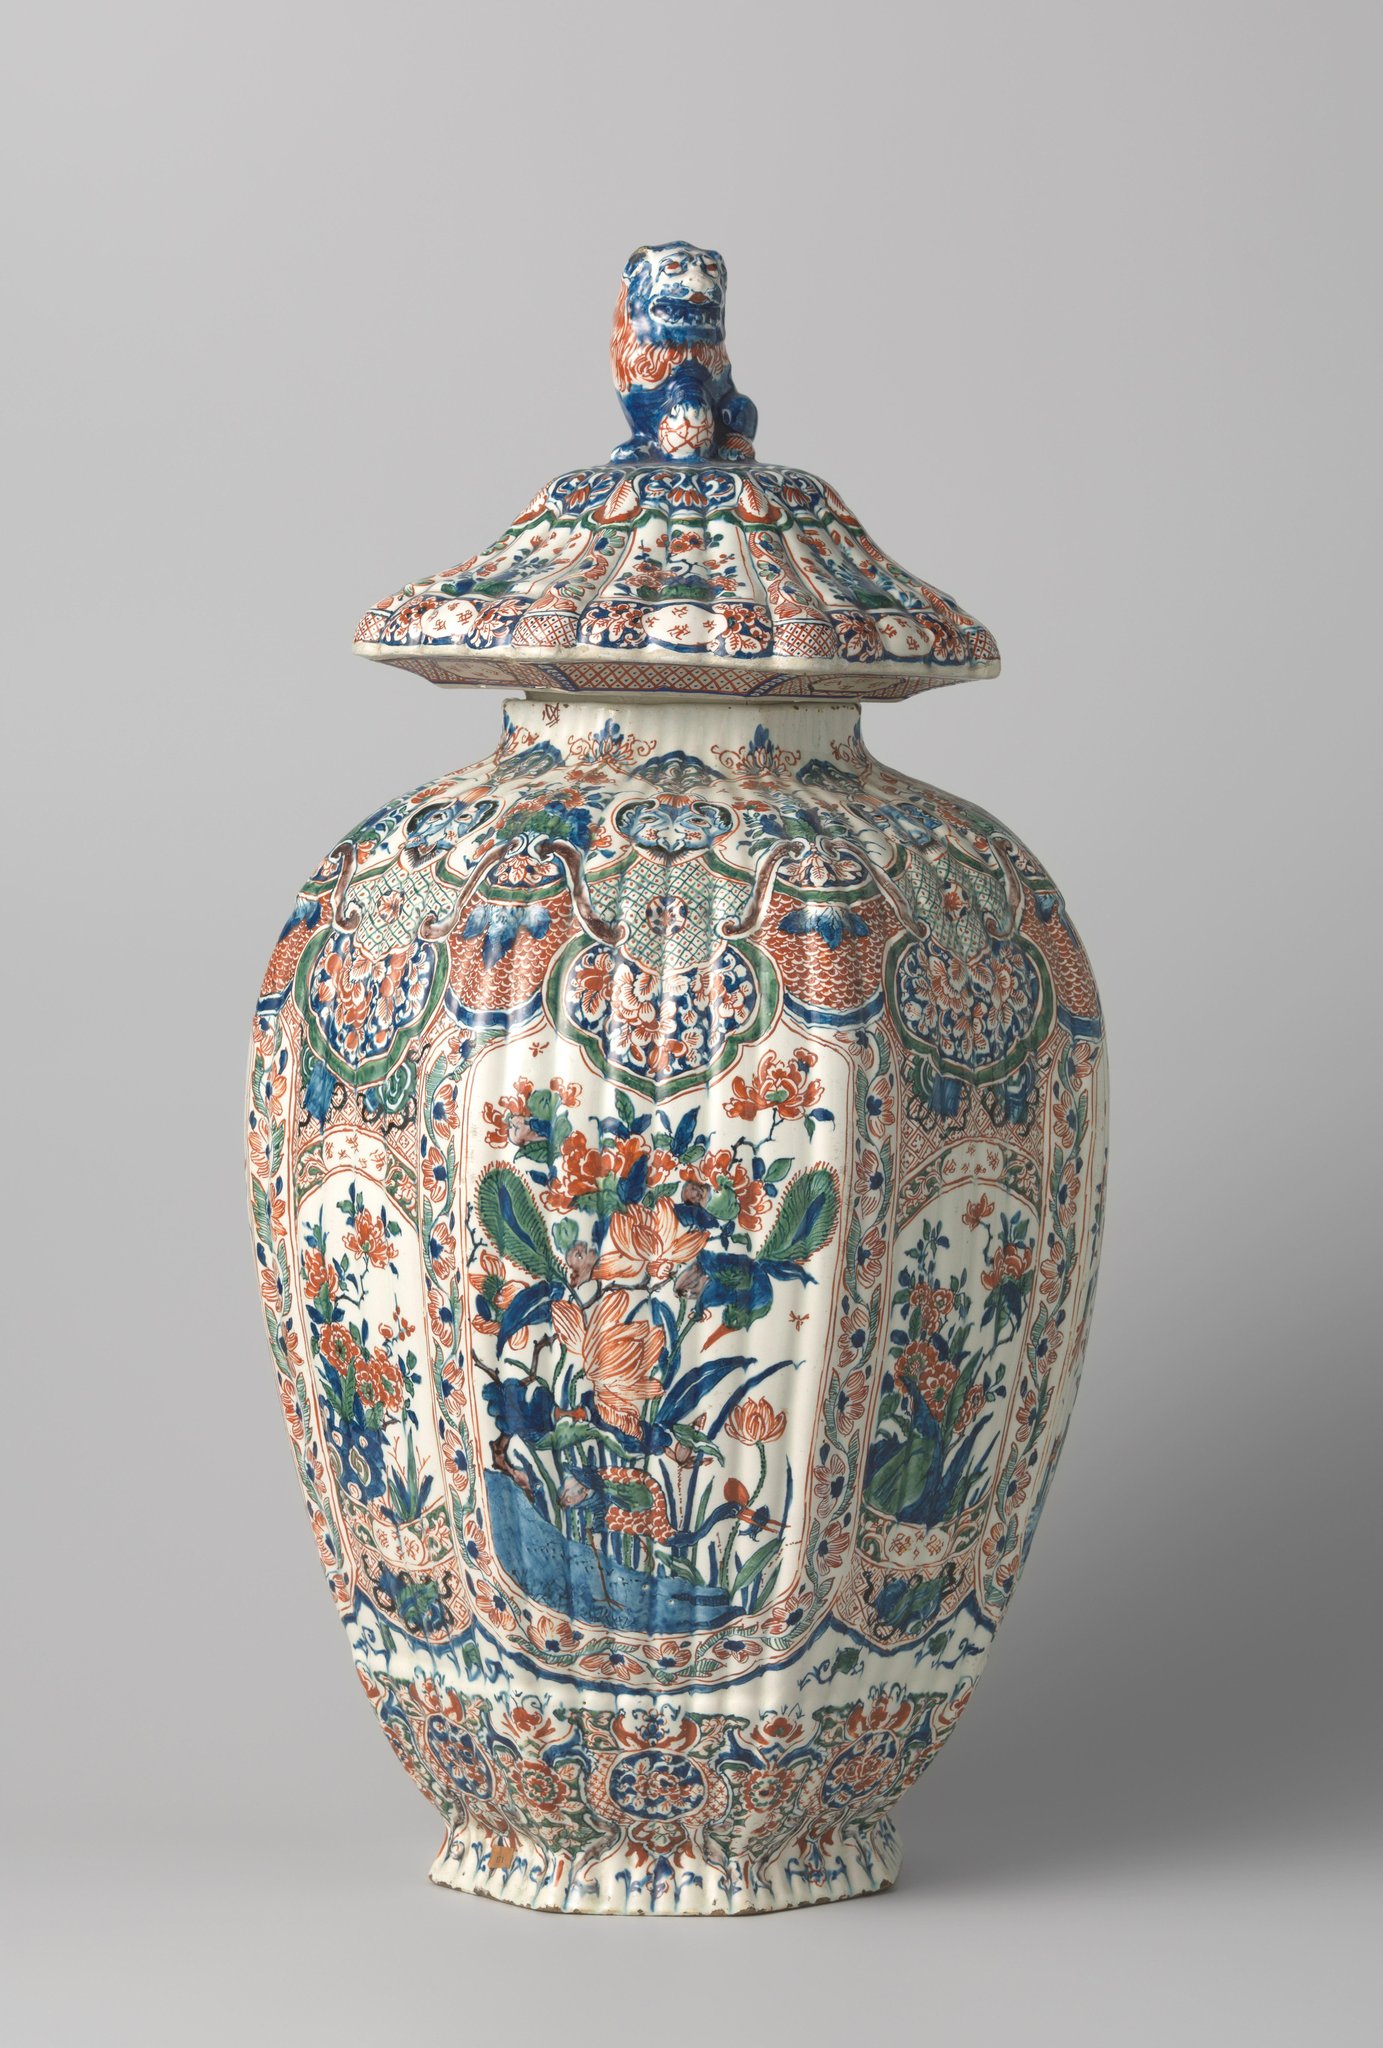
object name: vase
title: Vaas met deksel, veelkleurig beschilderd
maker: Anonymous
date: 1690-1720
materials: faience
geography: delft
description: Vaas van faïence. Veelkleurig beschilderd.